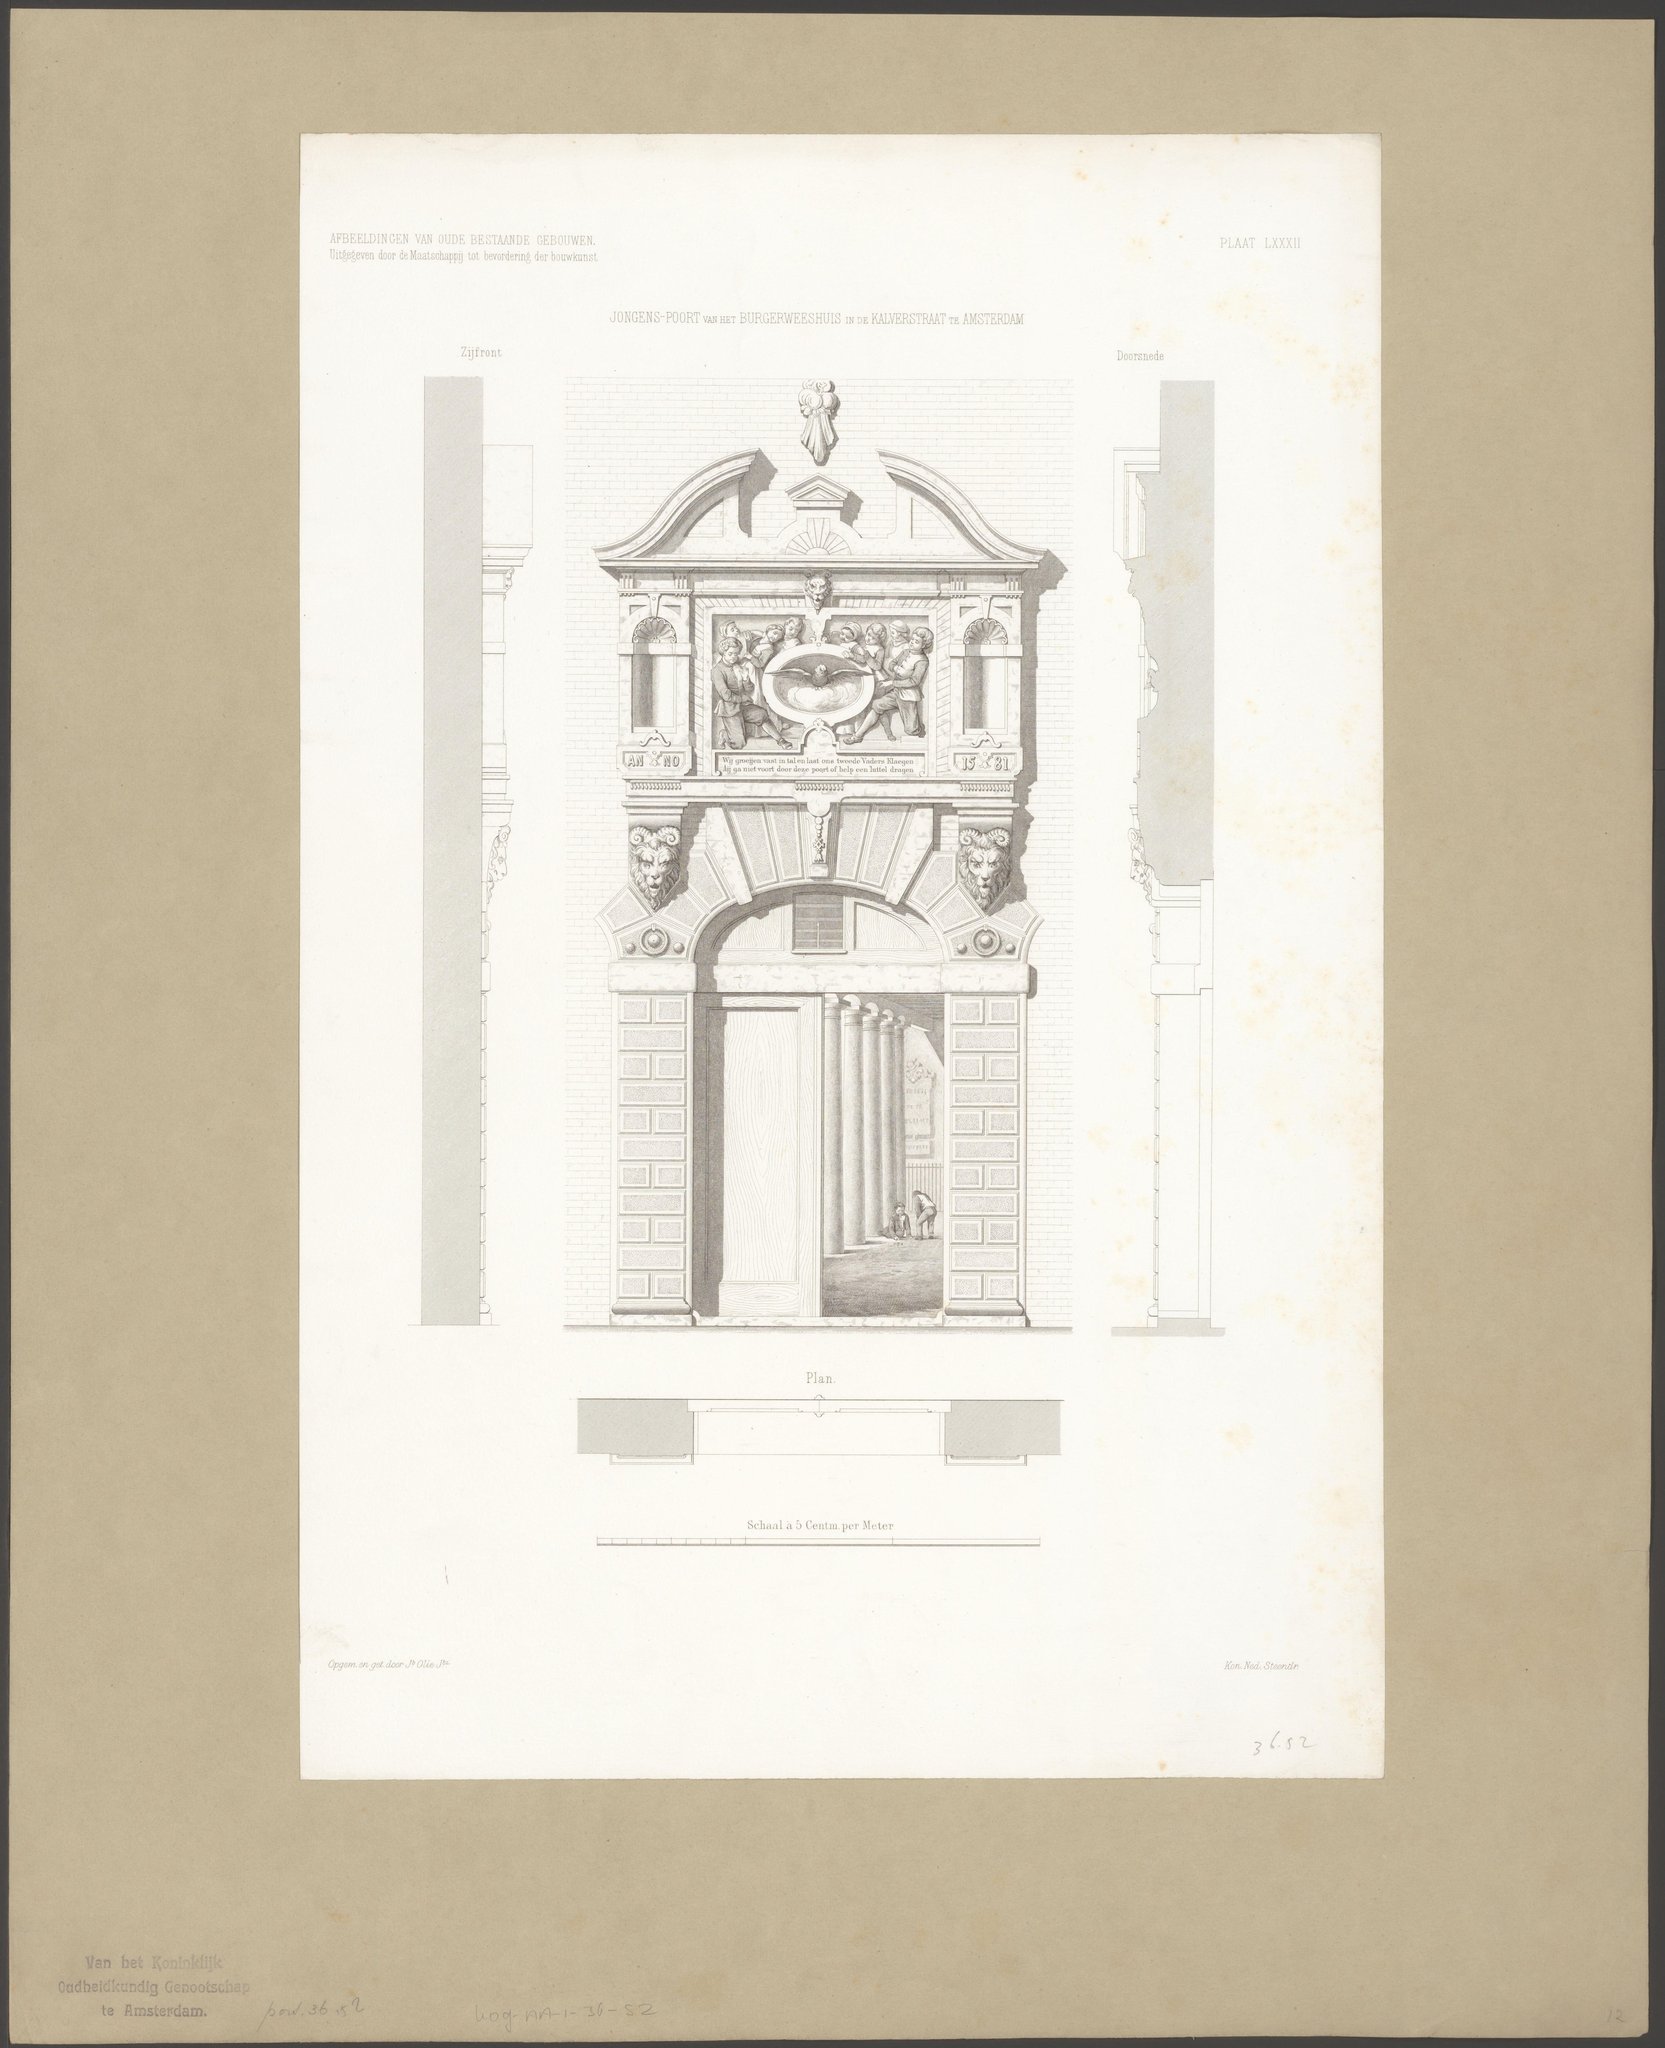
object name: print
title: Poort van het Burgerweeshuis te Amsterdam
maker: jacob jbz. olie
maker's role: fotograaf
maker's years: 1834-1905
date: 1842-1919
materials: paper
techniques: lithograph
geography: amsterdam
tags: gate, entrance, orphanage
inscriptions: collector's mark: ‘Van het Koninklijk Oudheidkundig Genootschap te Amsterdam’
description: Onderaan een plattegrond en een schaalroede. Rechtsboven genummerd: Plaat LXXXI. Onderwerpsrubriek binnen de Atlas Amsterdam: Armwezen en liefdadige instellingen: I. Stadsinrichtingen: Burgerweeshuis.